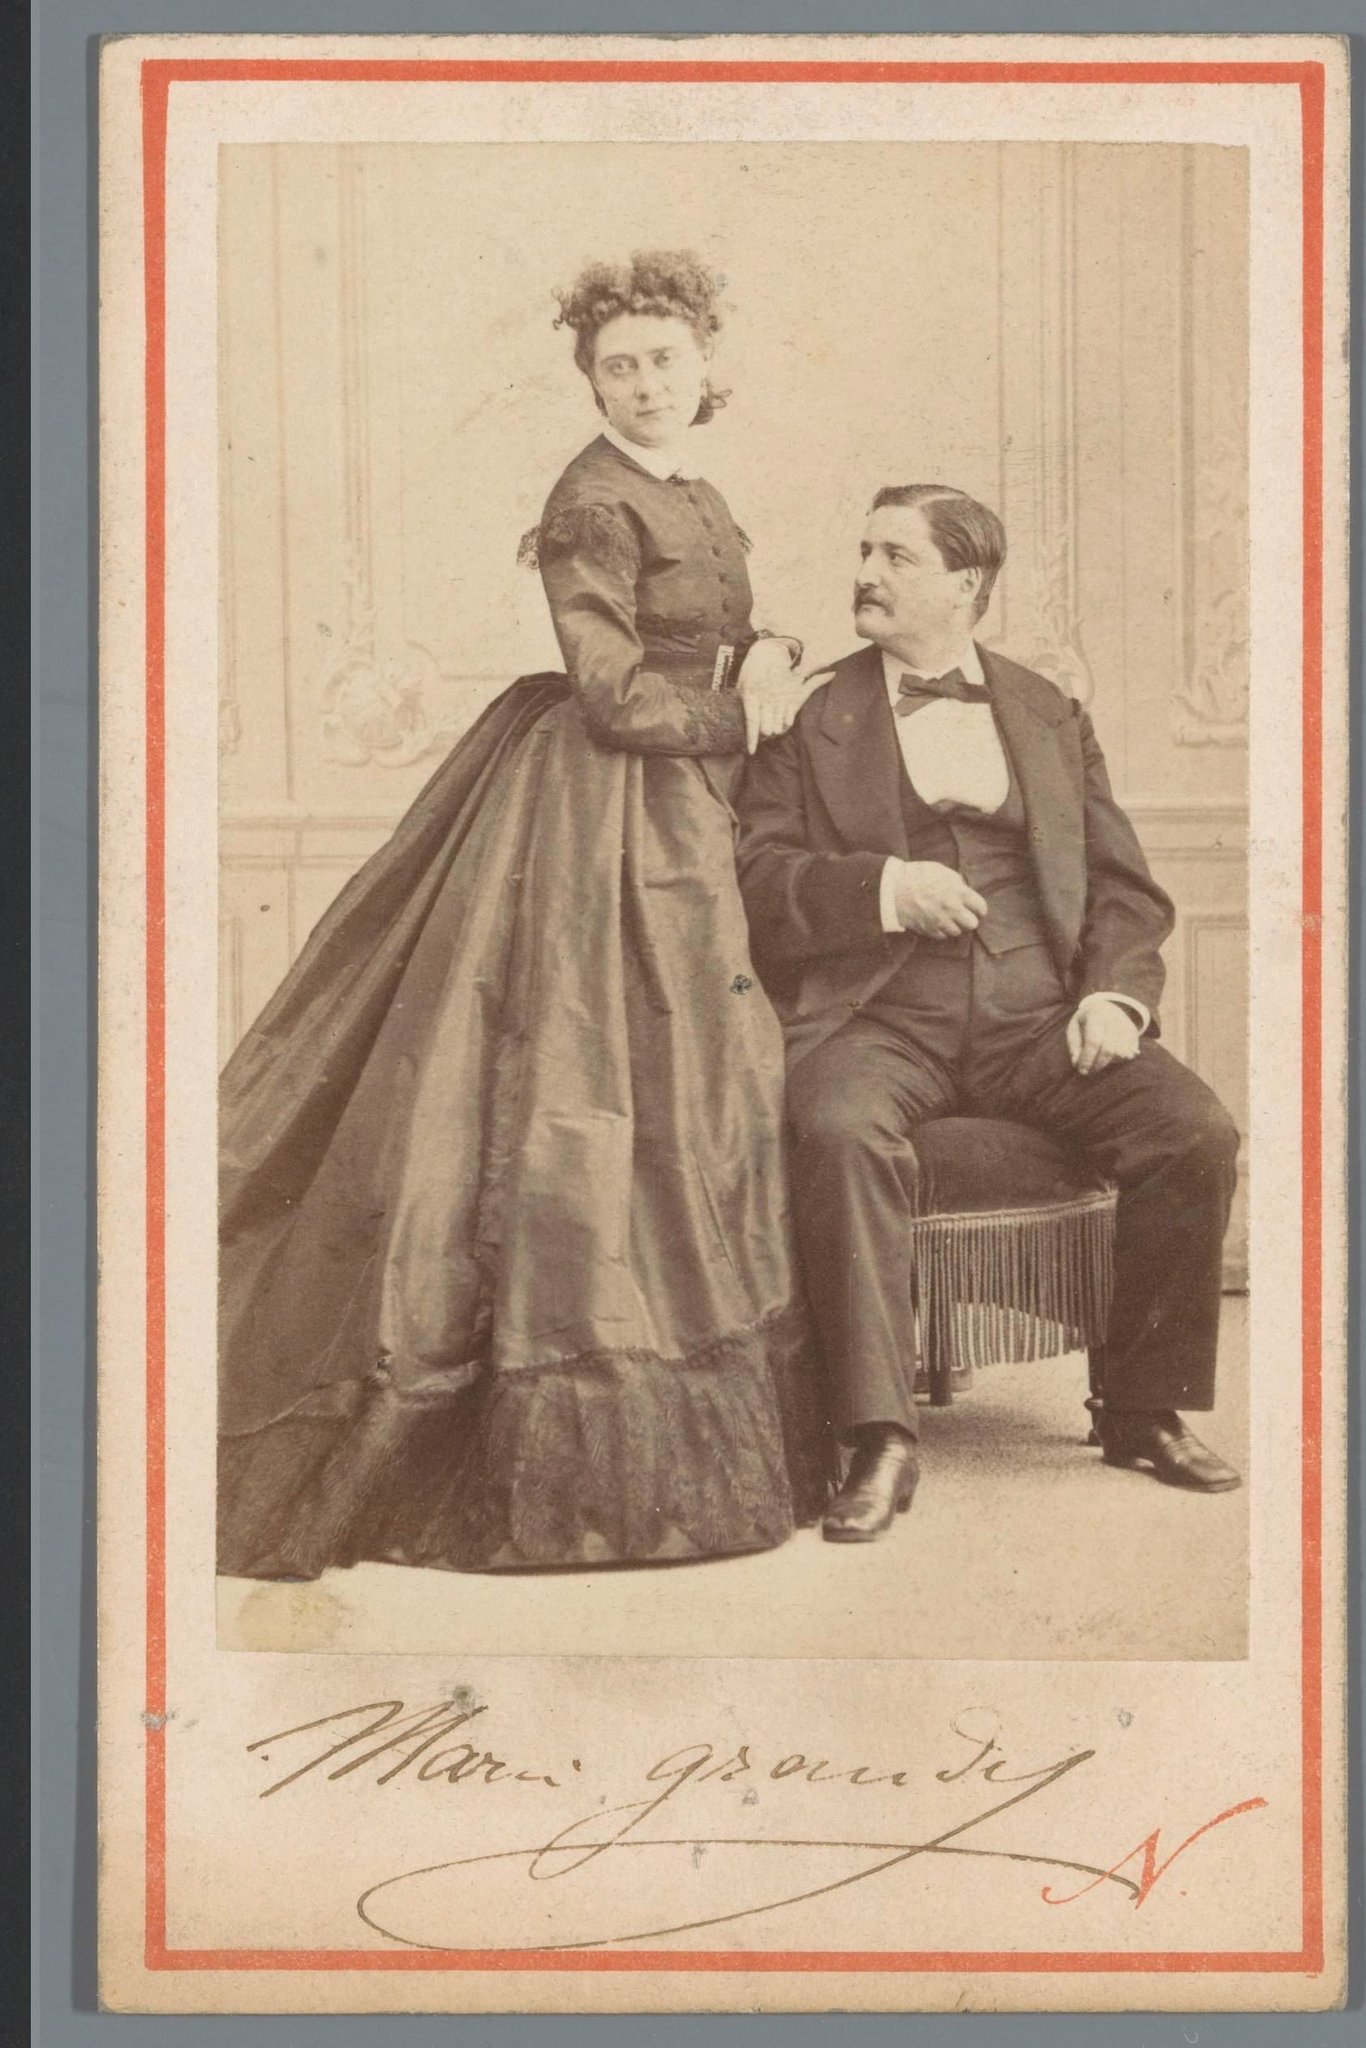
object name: carte de visite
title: Portret van een onbekende man en vrouw, aangeduid als Marie Grandes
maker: félix nadar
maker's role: ballonvaarder, fotograaf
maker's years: 1820-1910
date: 1872-1873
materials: cardboard, paper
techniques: albumen print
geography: paris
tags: adult woman, adult man, historical persons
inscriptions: inscription: ‘Marie Grandes’, inscription: ‘PHOTOGRAPHIE DU GRAND HÔTEL/ Nadar/ 35, Boulevart des Capucines.’